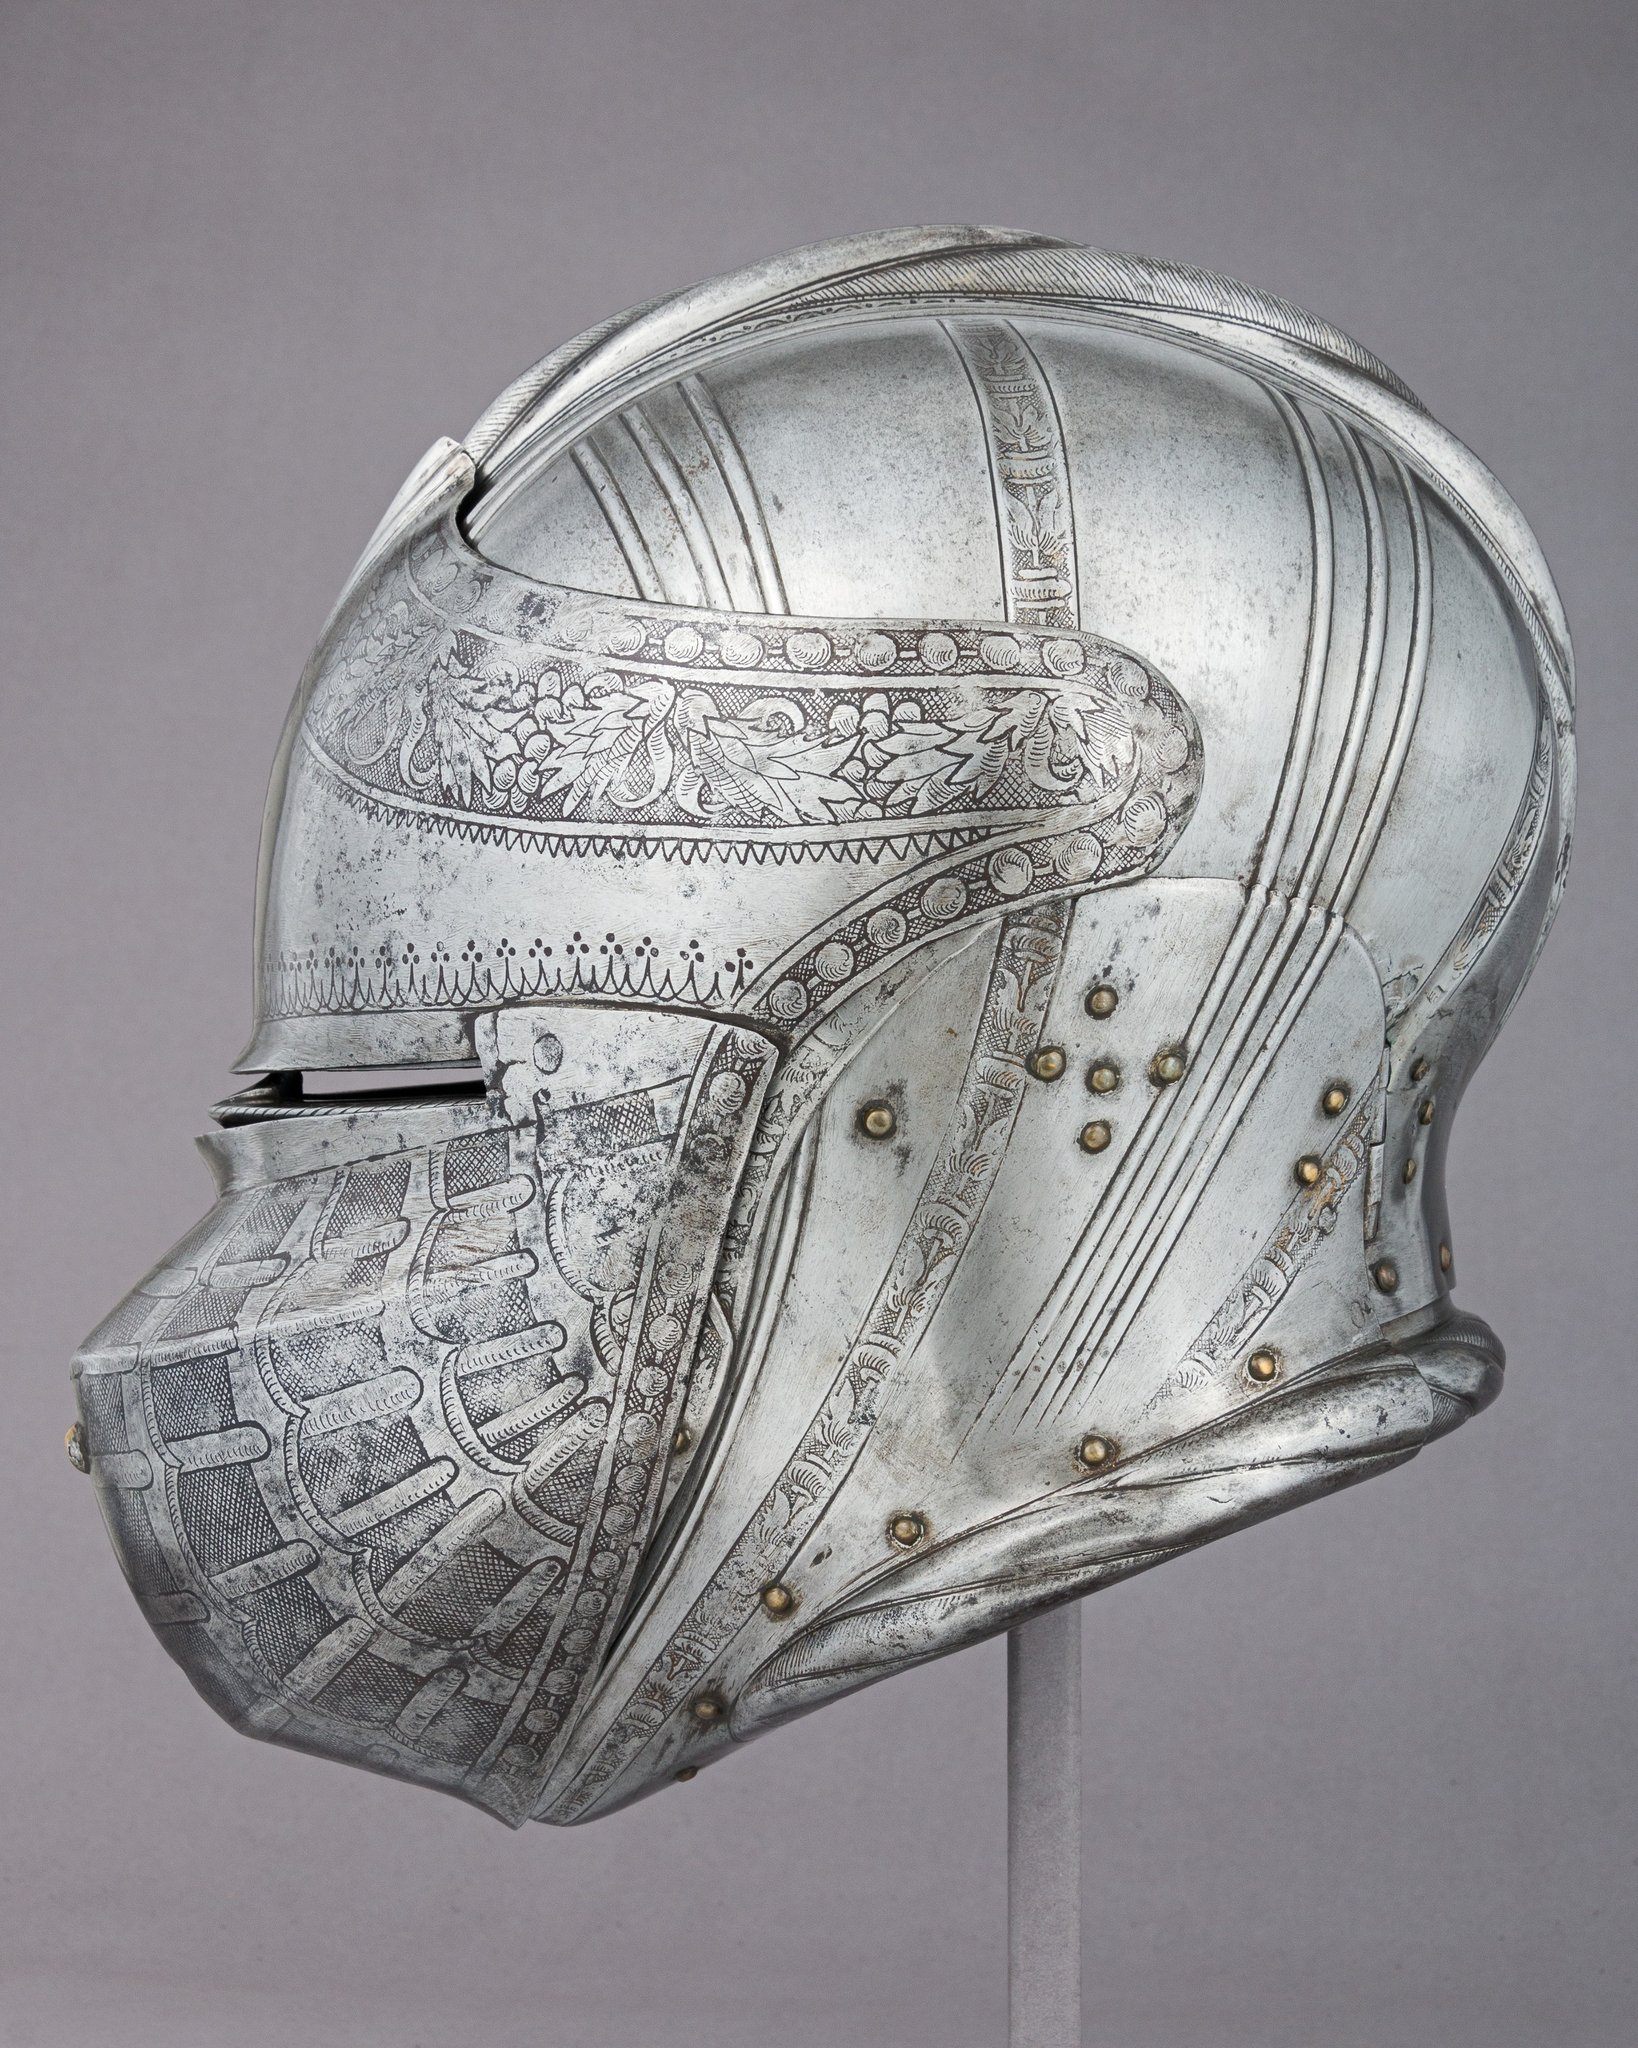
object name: armet for the tourney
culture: german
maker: kolman helmschmid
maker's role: armorer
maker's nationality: german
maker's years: 1471-1532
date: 1515-1520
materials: copper alloy, steel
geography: germany